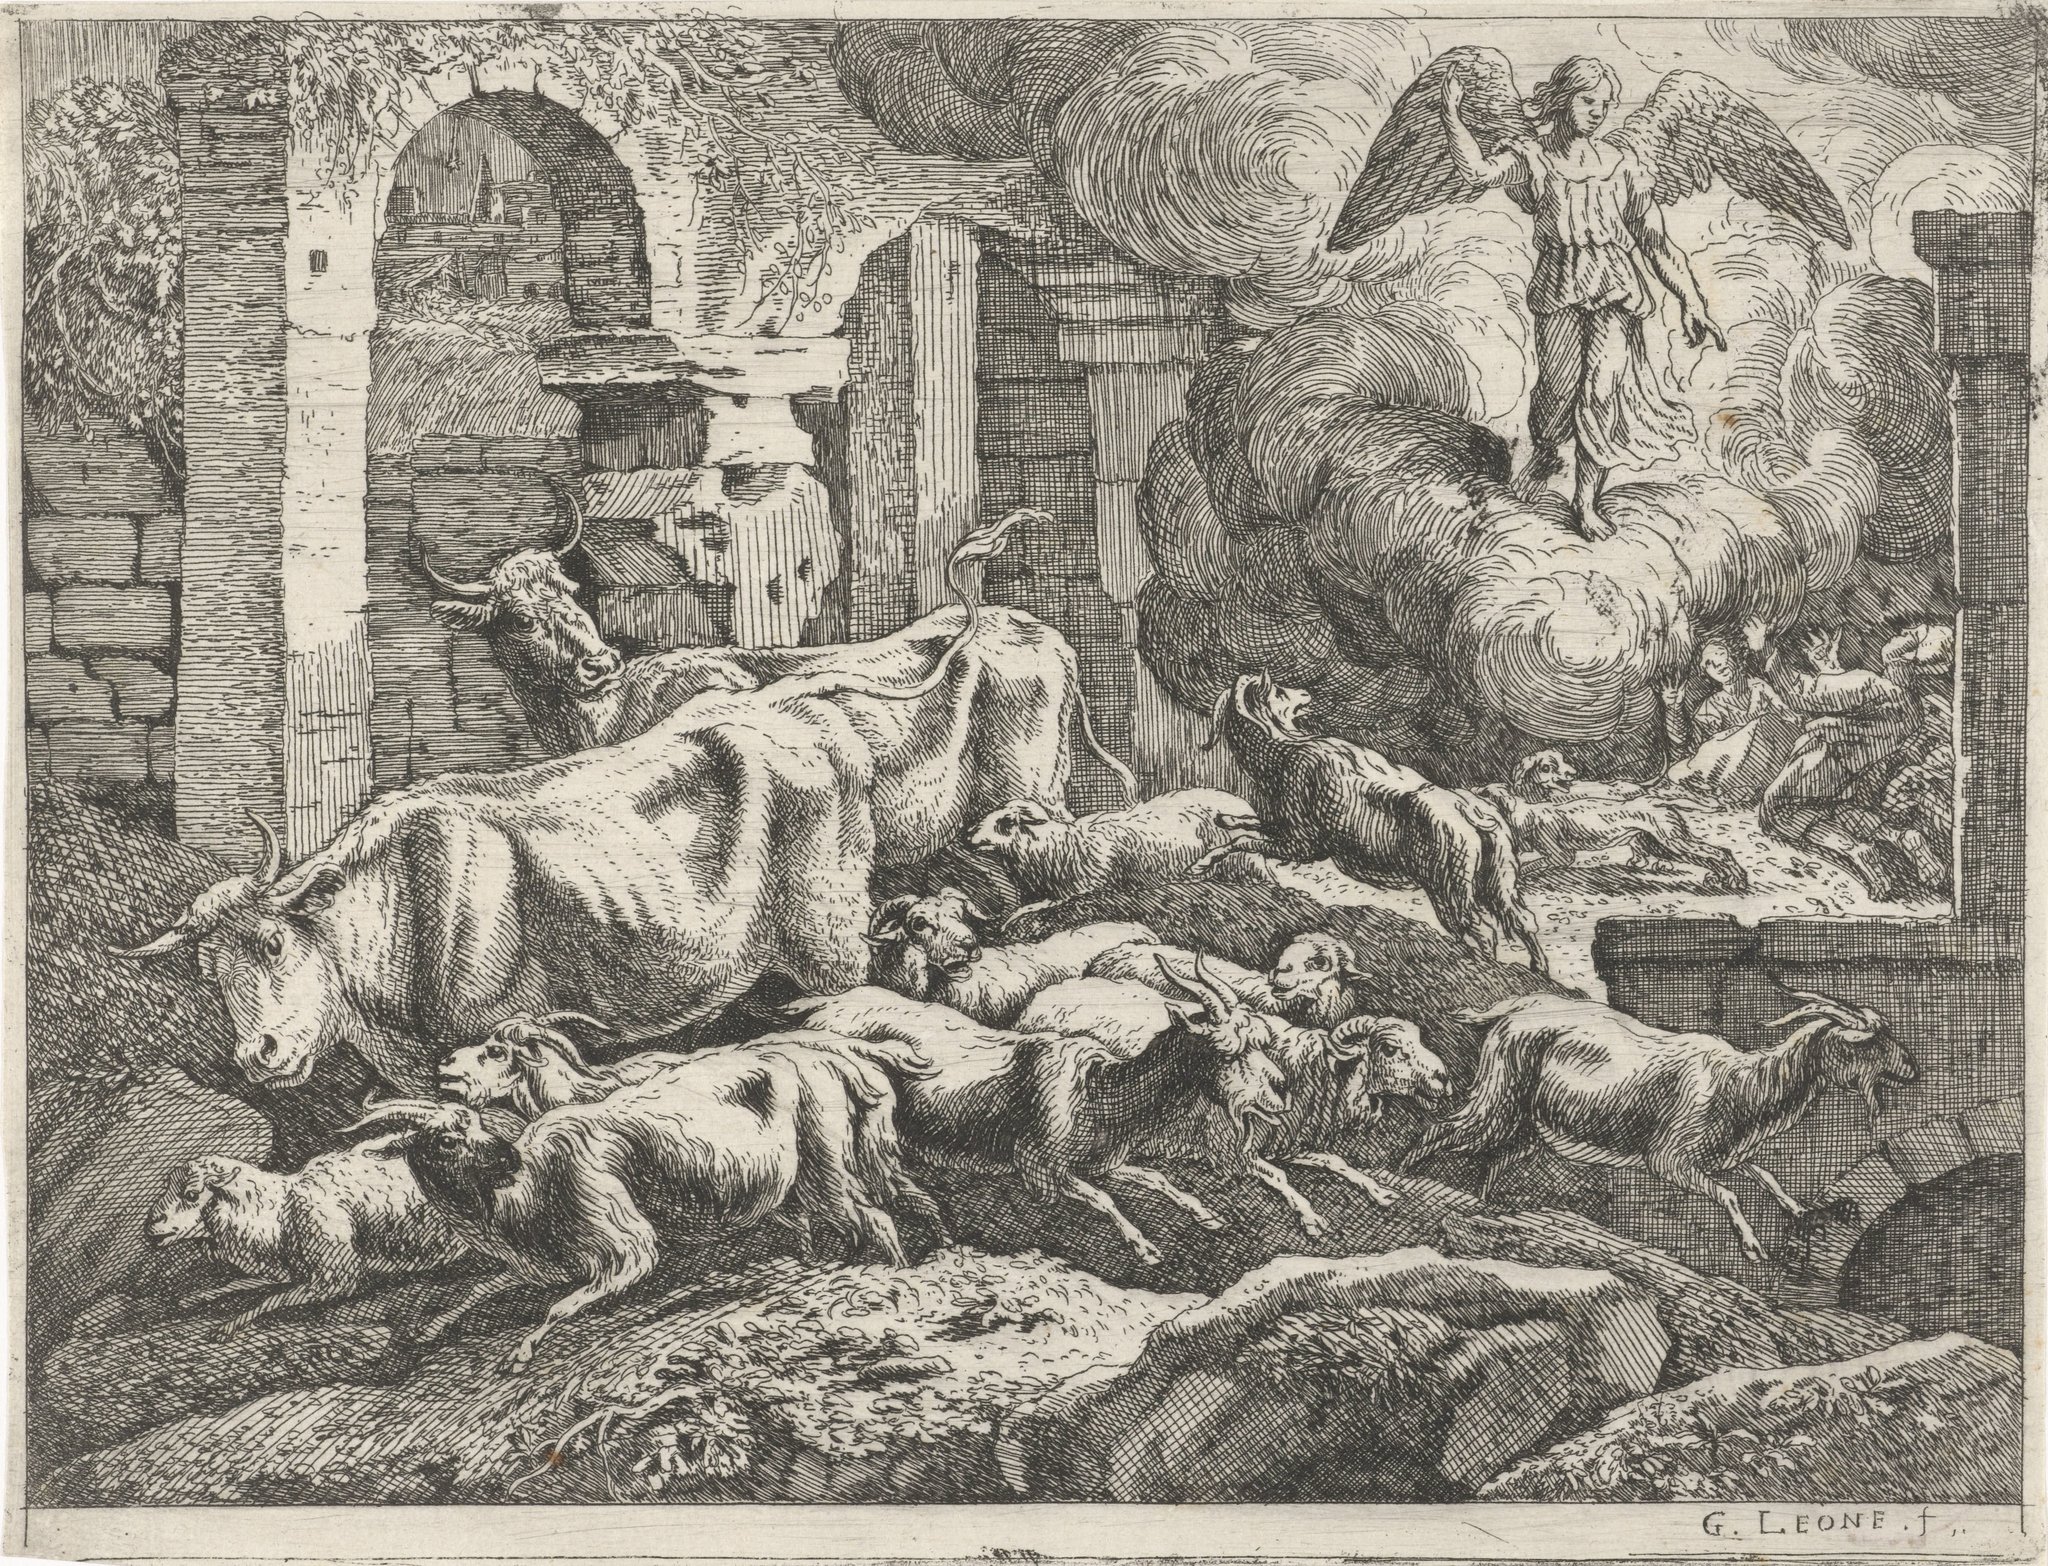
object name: print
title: Verkondiging aan de herders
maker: govert van der leeuw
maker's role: print maker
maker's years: 1645-1688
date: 1655-1688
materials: paper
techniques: etching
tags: annunciation of christ's birth to the shepherds (and/or shepherdesses) at night; a host of singing angels in the air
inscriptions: collector's mark: Lugt 240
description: Landschap met ruïnes, op de voorgrond slaat een kudde schapen, geiten en koeien op de vlucht. Op de achtergrond verkondigt een engel de geboorte van Christus aan de herders.